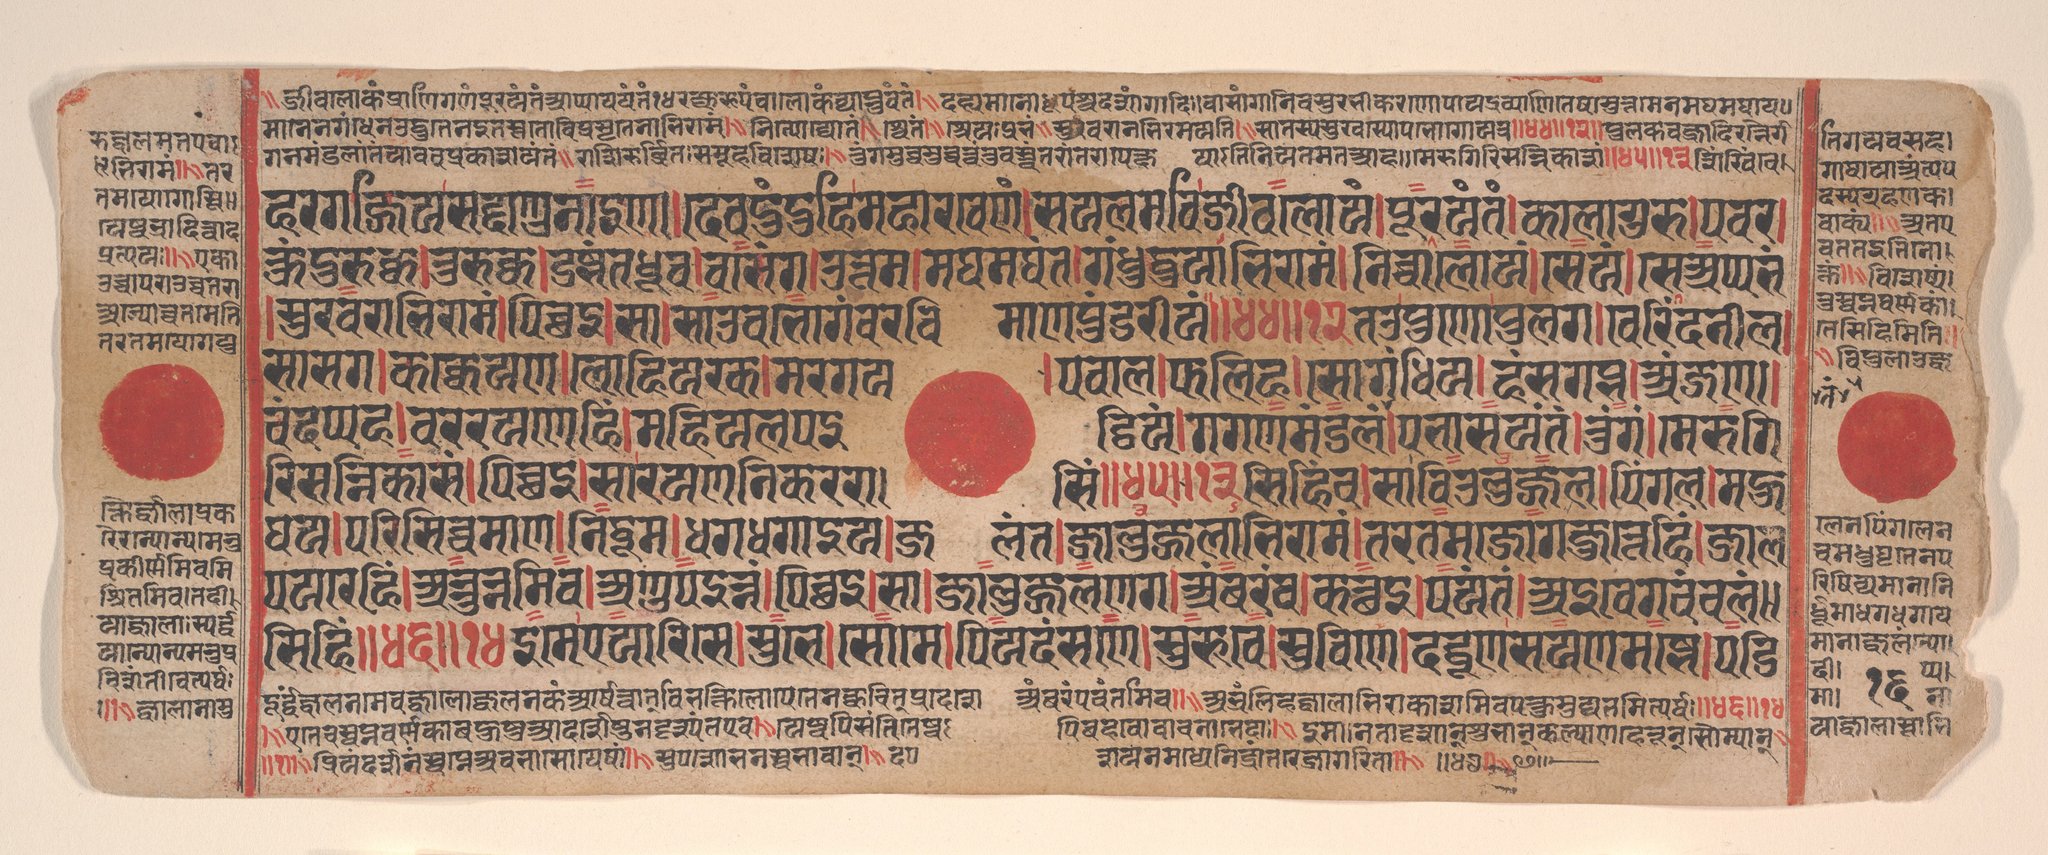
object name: folio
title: Leaf from a Kalpa Sutra (Jain Book of Rituals)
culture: indian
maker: bhadrabahu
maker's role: artist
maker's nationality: indian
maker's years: 356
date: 1401-1500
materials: gold, ink, paper, watercolor